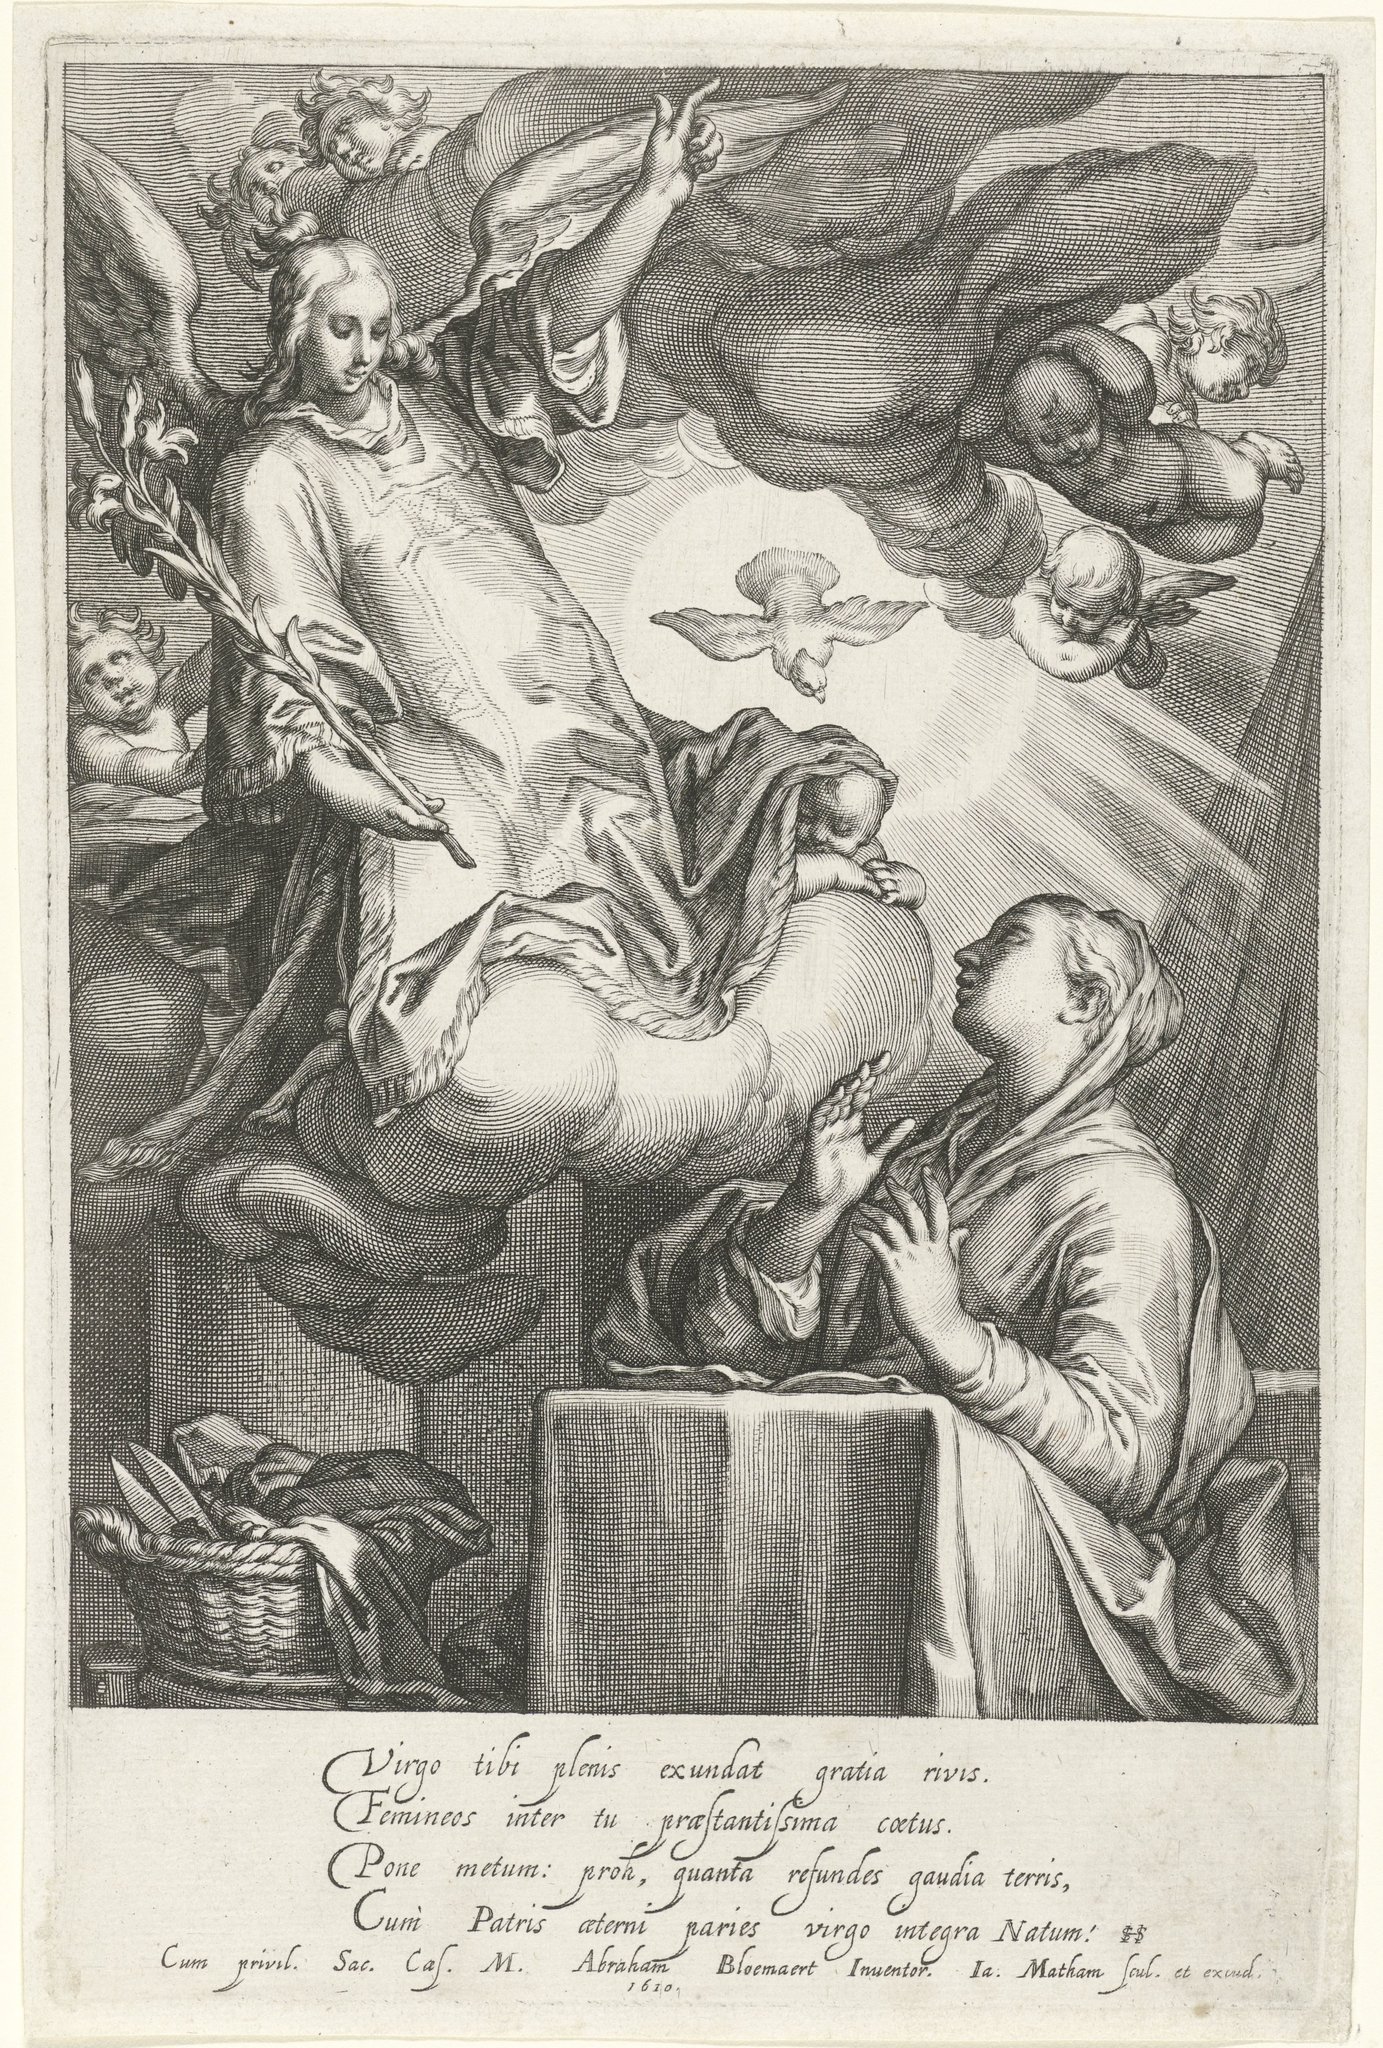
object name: print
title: Annunciatie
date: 1610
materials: paper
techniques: engraving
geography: haarlem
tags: the annunciation: mary, usually reading, is visited by the angel (sometimes a woman overhears the conversation)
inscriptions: collector's mark: Lugt 240